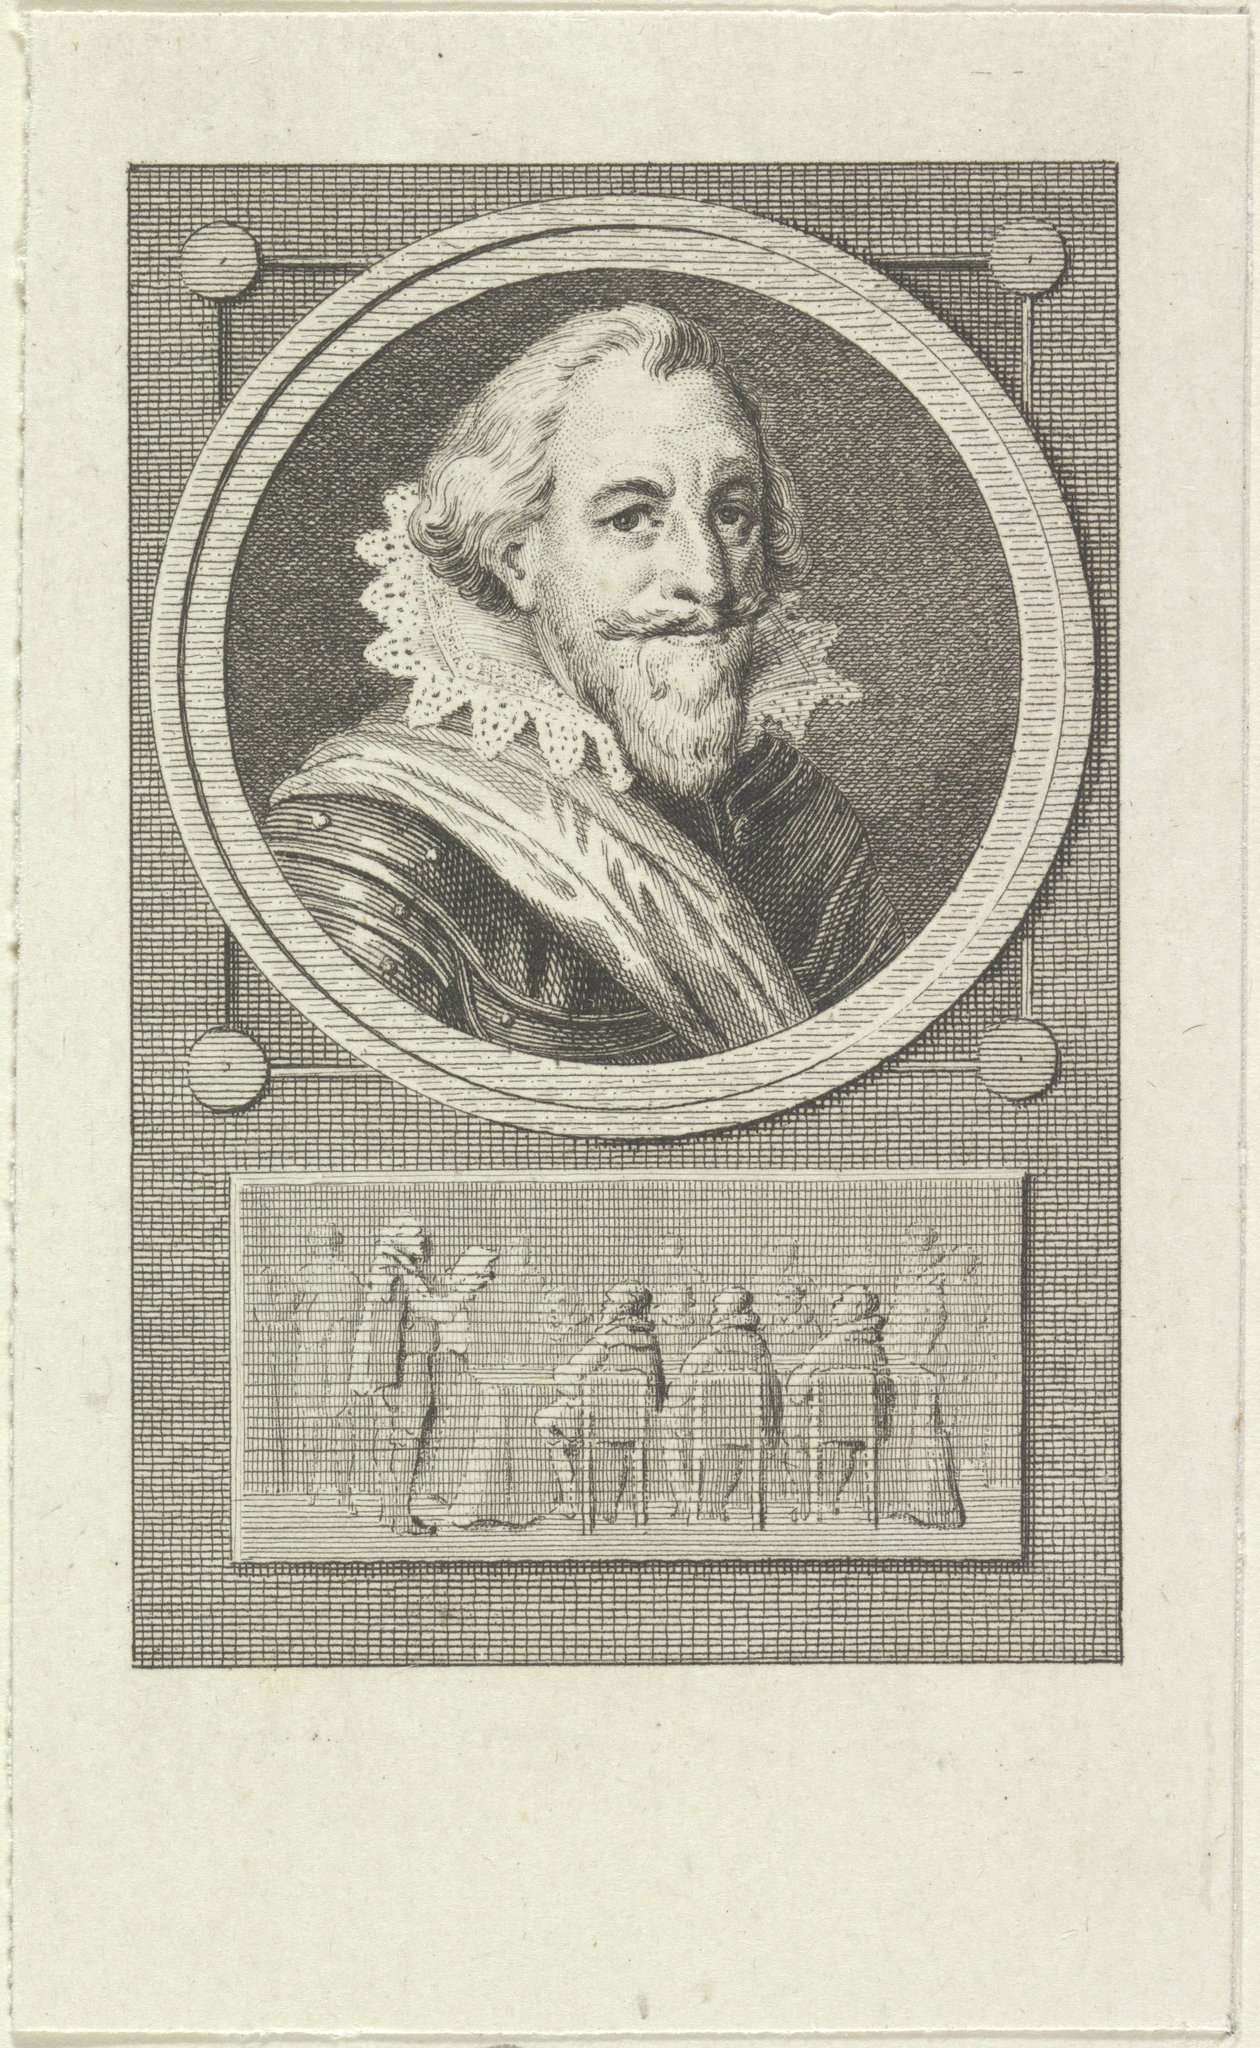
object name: print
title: Portret van Johan VII, graaf van Nassau-Siegen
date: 1771-1816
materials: paper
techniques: engraving, etching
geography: amsterdam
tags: dillenburg, siegen, johan vii graaf van nassau-siegen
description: De hier vermelde titel verwijst naar de hoogst verkregen titel van de geportretteerde, niet per se naar de titel die de geportretteerde op deze voorstelling draagt.